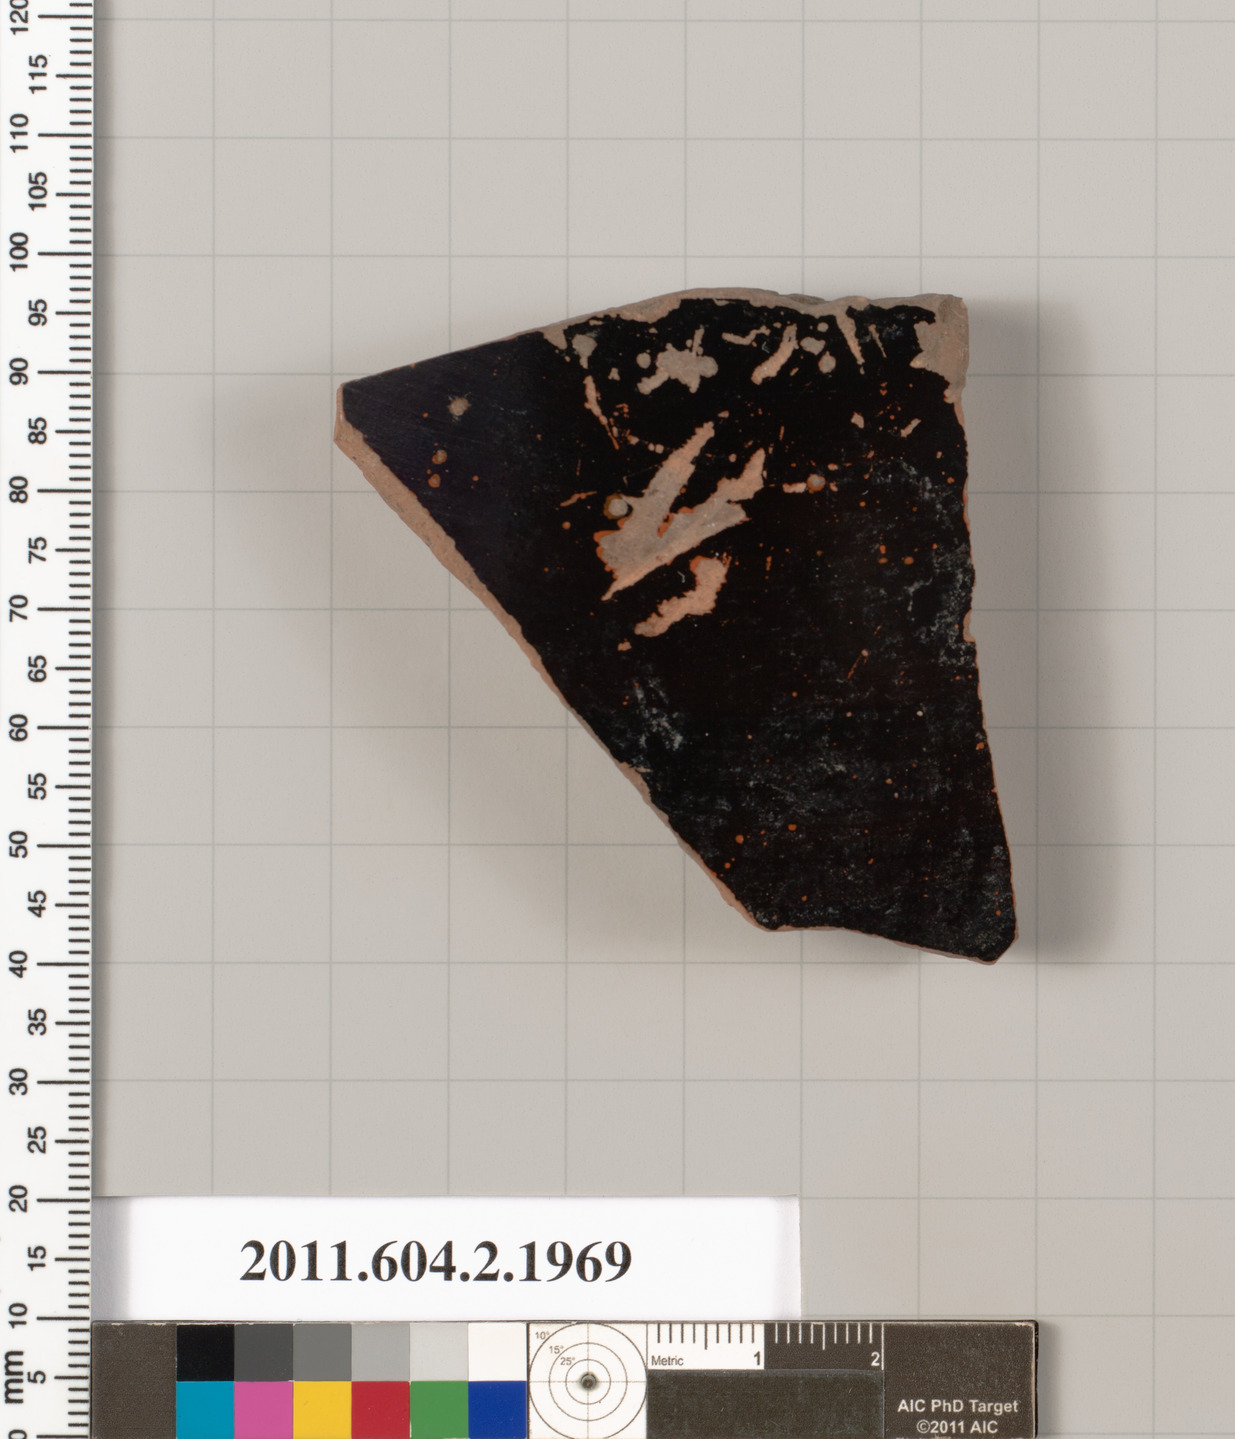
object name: krater fragment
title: Terracotta fragment of a krater (bowl for mixing wine and water)?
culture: greek, attic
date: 475-451 BCE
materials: terracotta